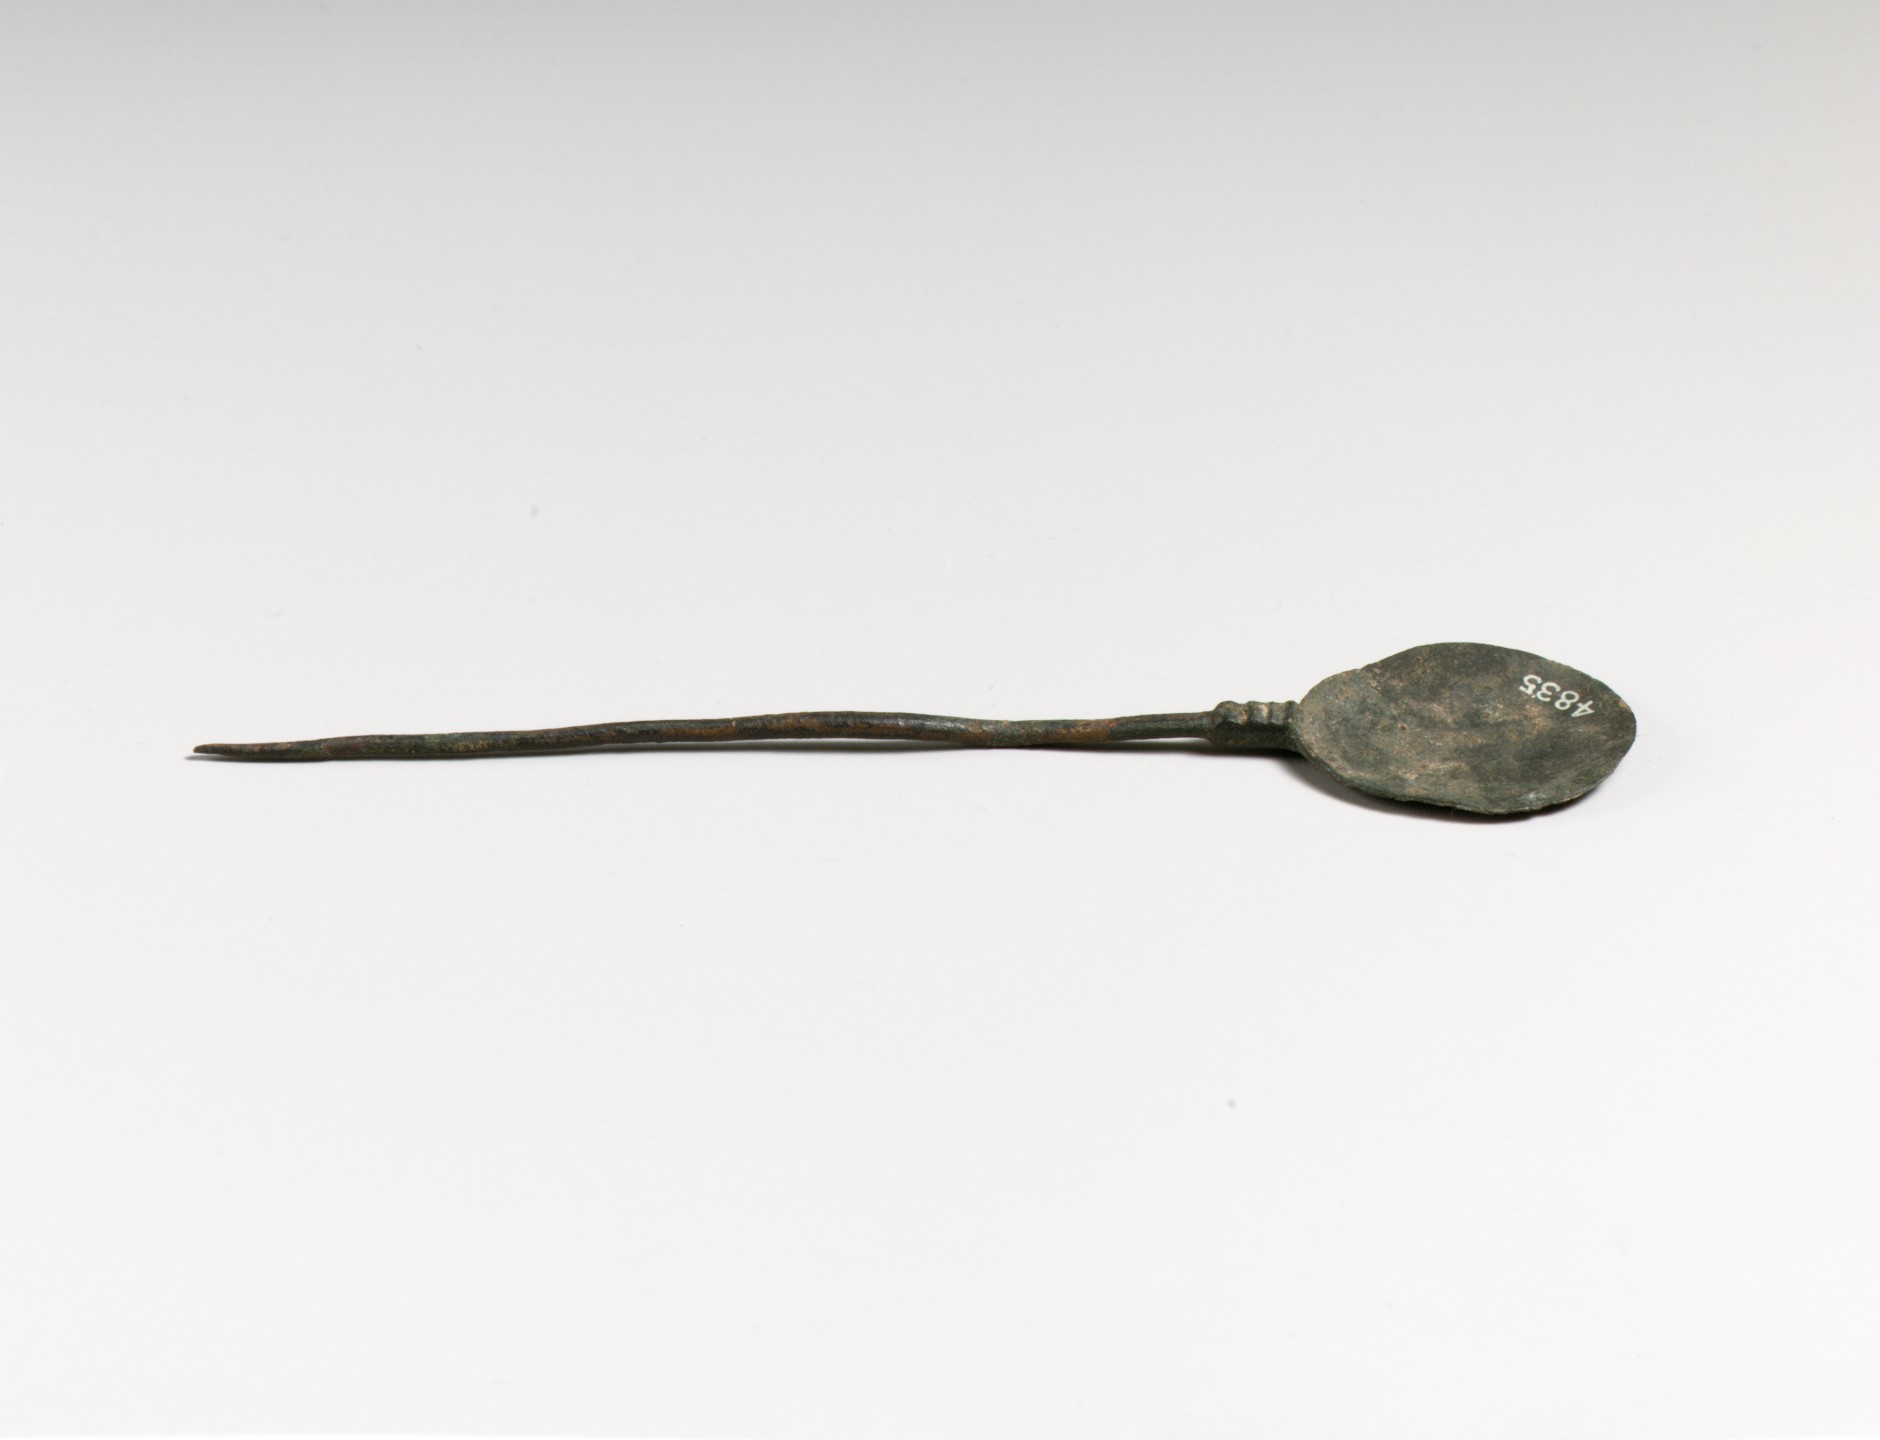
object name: spoon probe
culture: cypriot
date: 3900 BCE-100 CE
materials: bronze